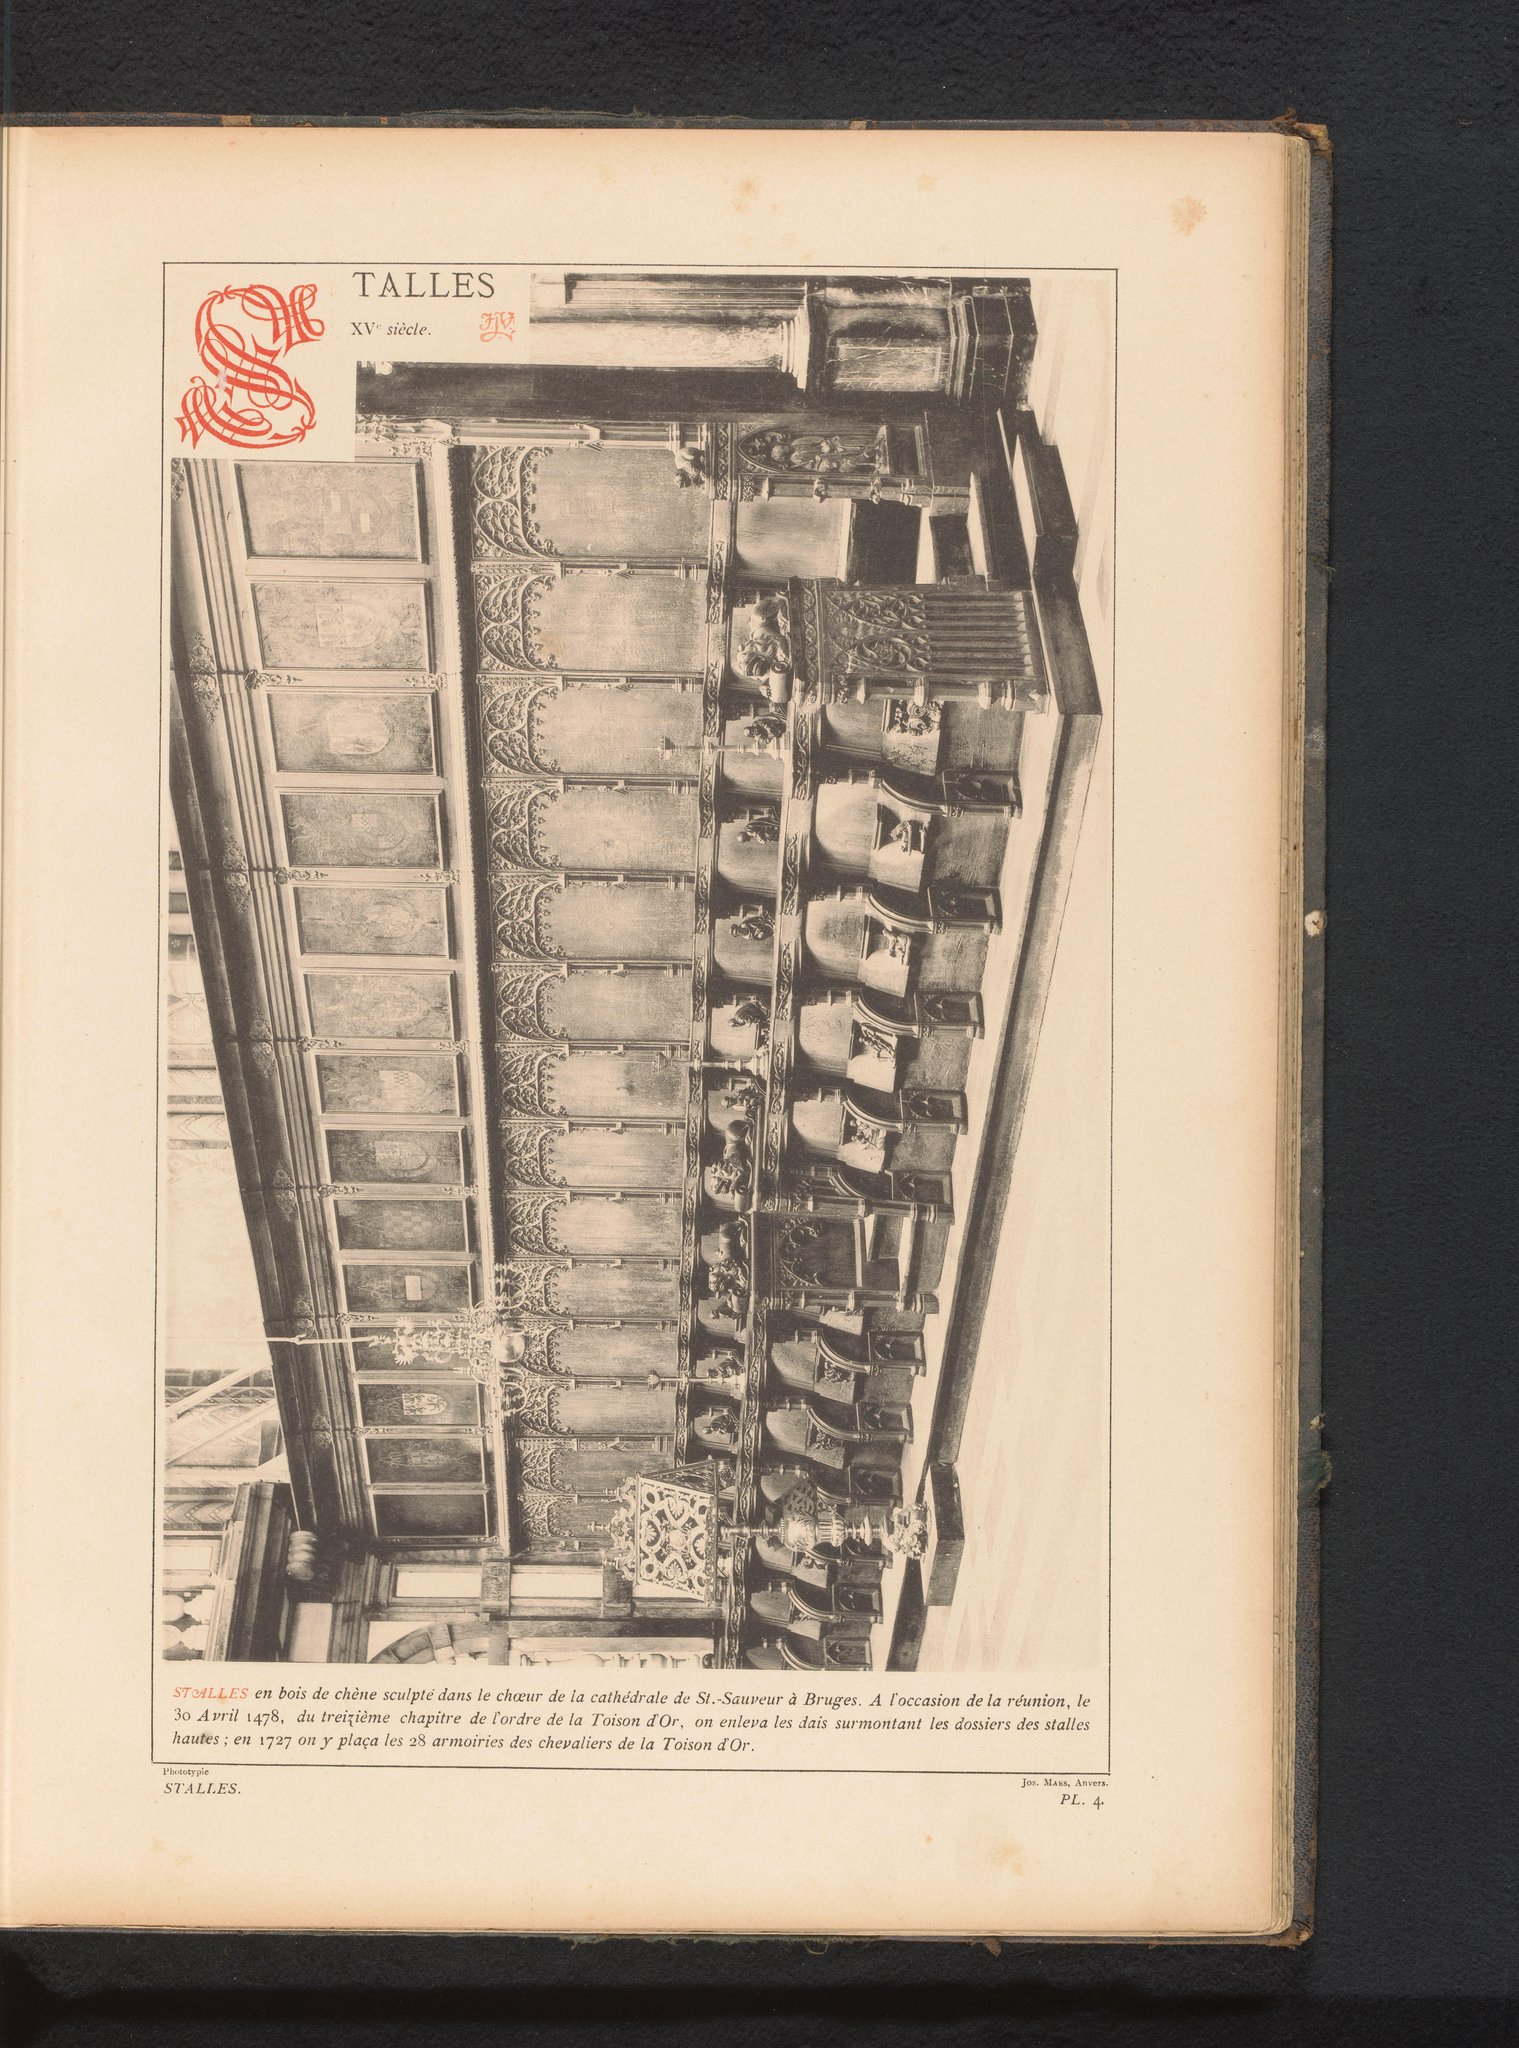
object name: photomechanical print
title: Koorbank van eikenhout in de Sint-Salvatorskathedraal in Brugge, België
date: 1882-1887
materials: paper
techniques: photograph, photolithography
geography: antwerp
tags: bench, parts of church interior: choir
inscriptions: inscription: ‘STALLES. - PL. 4.’, inscription: ‘STALLES en bois (...)’, monogram: ‘JJvY’